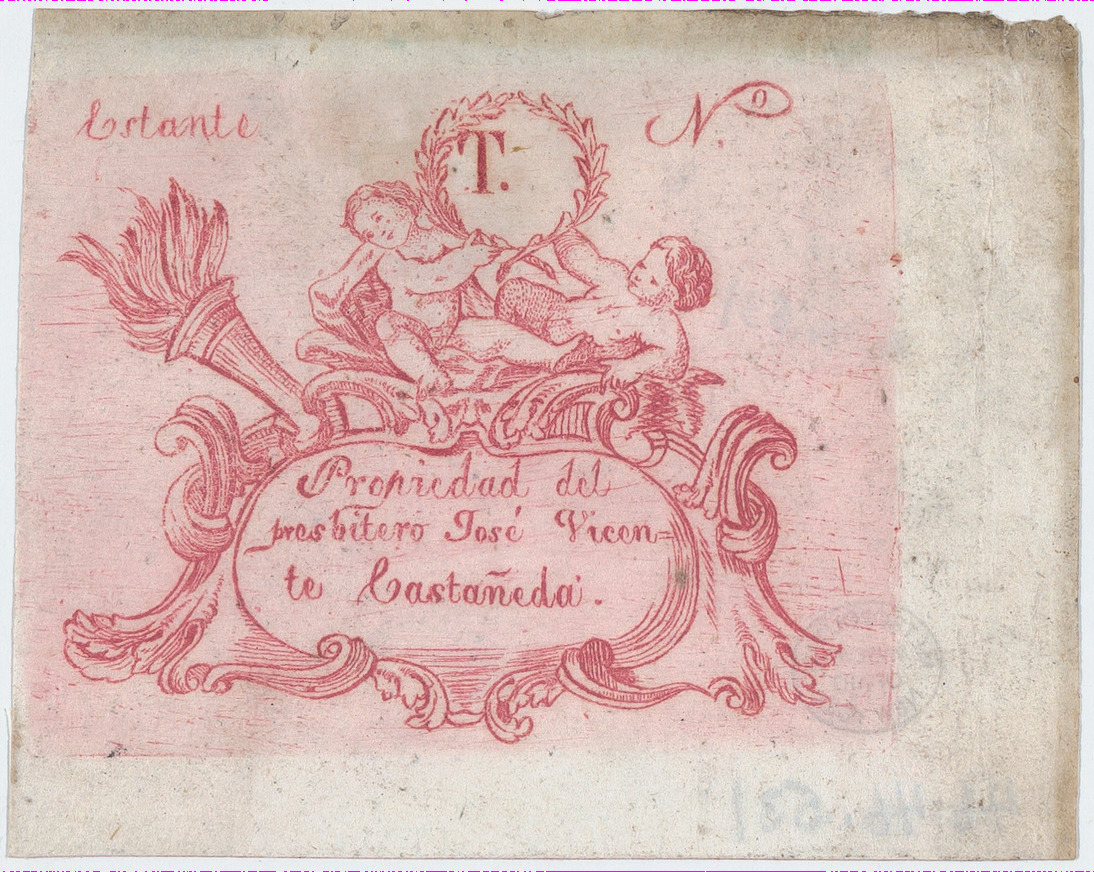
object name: print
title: Ornament plaque with angels on top holding a wreath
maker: anonymous, mexican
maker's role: artist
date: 1800-1899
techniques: engraving, printing